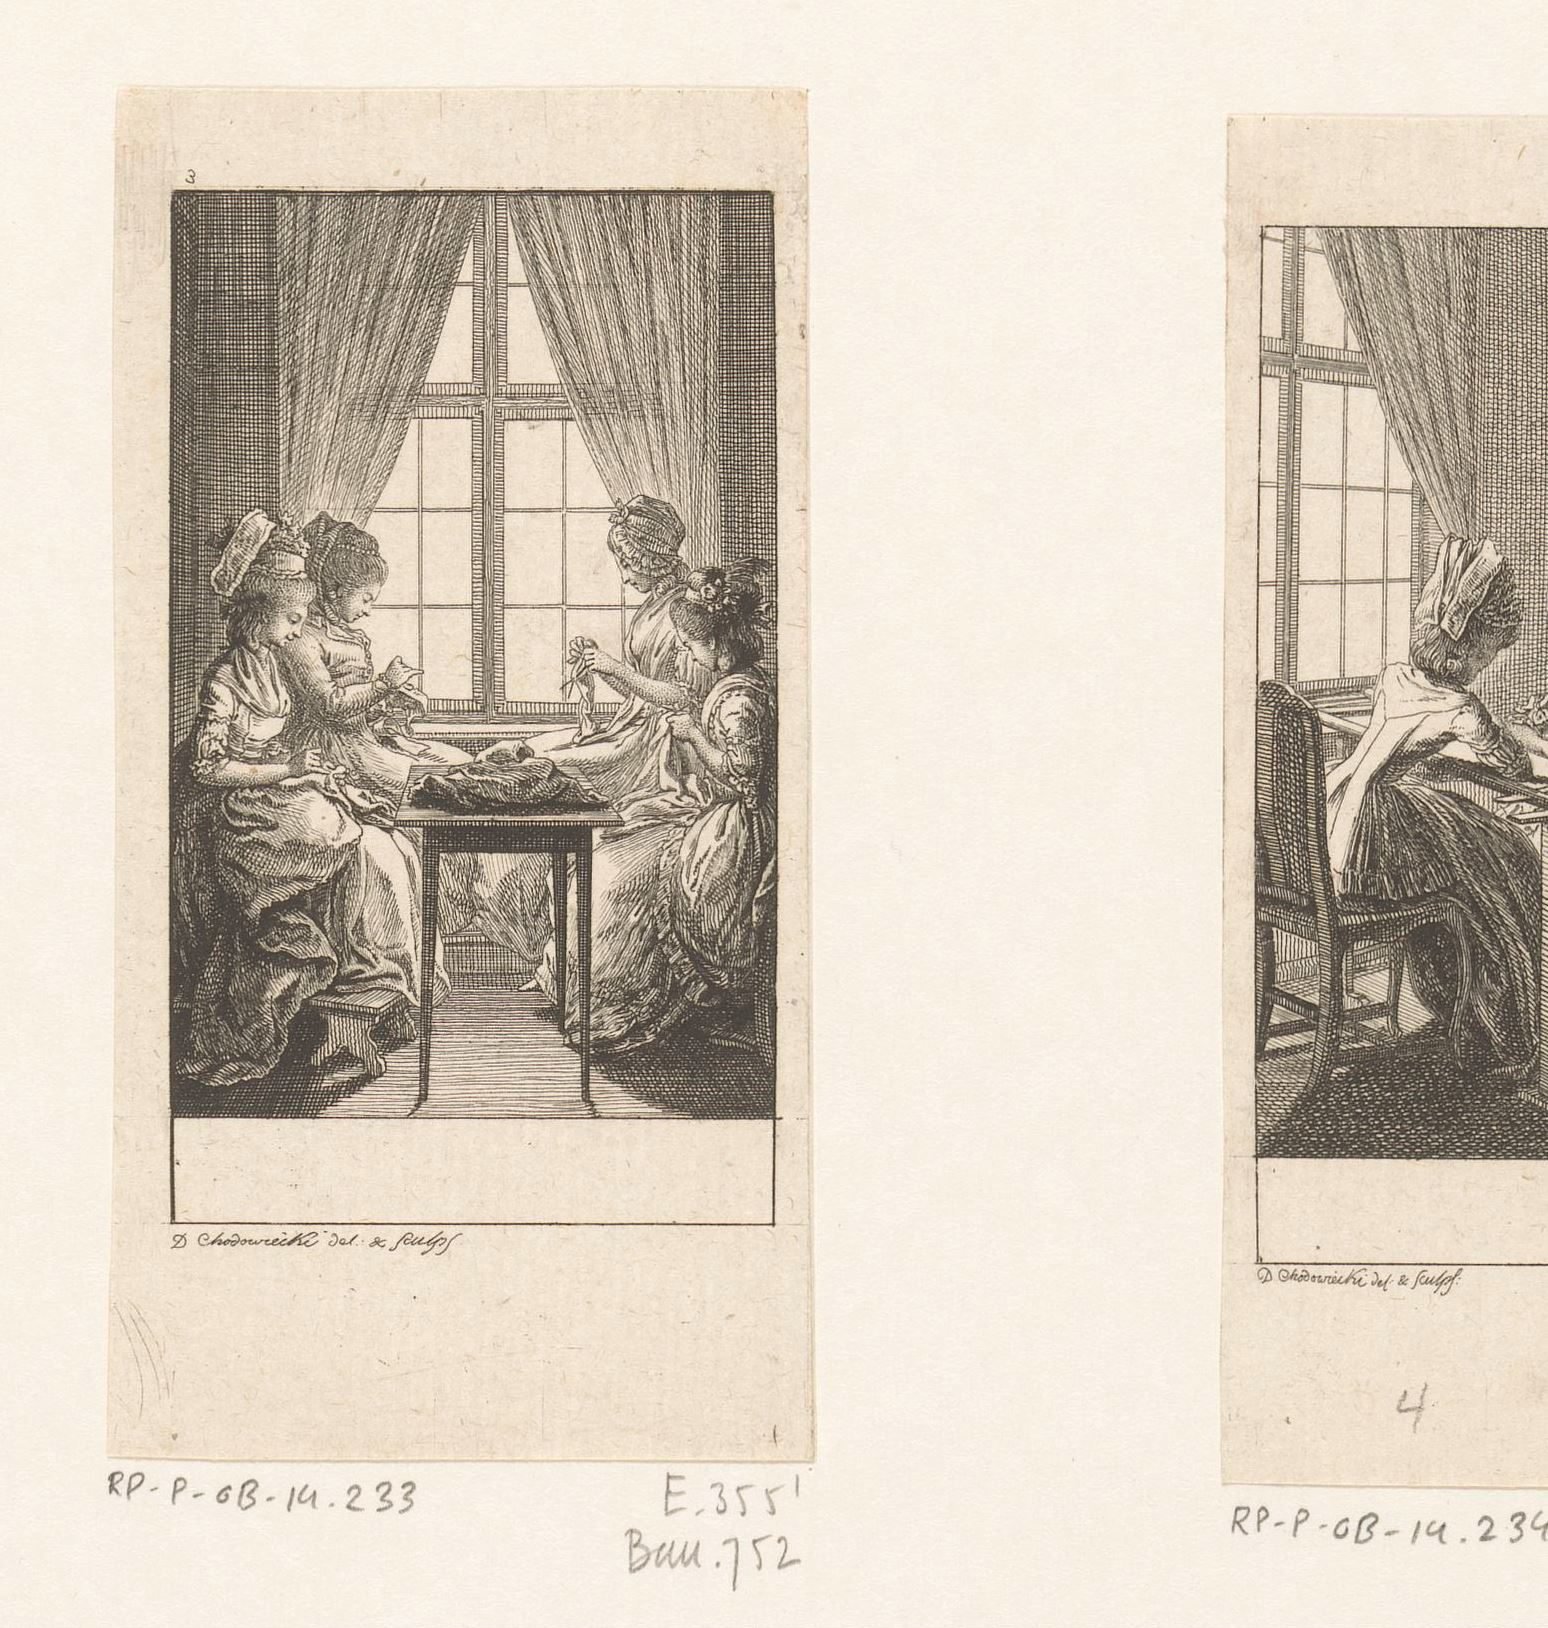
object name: print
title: Naaiende dames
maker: daniel nikolaus chodowiecki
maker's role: draughtsman, print maker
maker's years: 1726-1801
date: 1780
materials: paper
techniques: etching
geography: berlin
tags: sewing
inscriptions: collector's mark: Lugt 2228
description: Prent gebruikt voor: Almanac Généalogique pour l'année 1781 (...). S.l.s.n., [1780]. Een serie van twaalf prenten betreffende bezigheden voor dames.